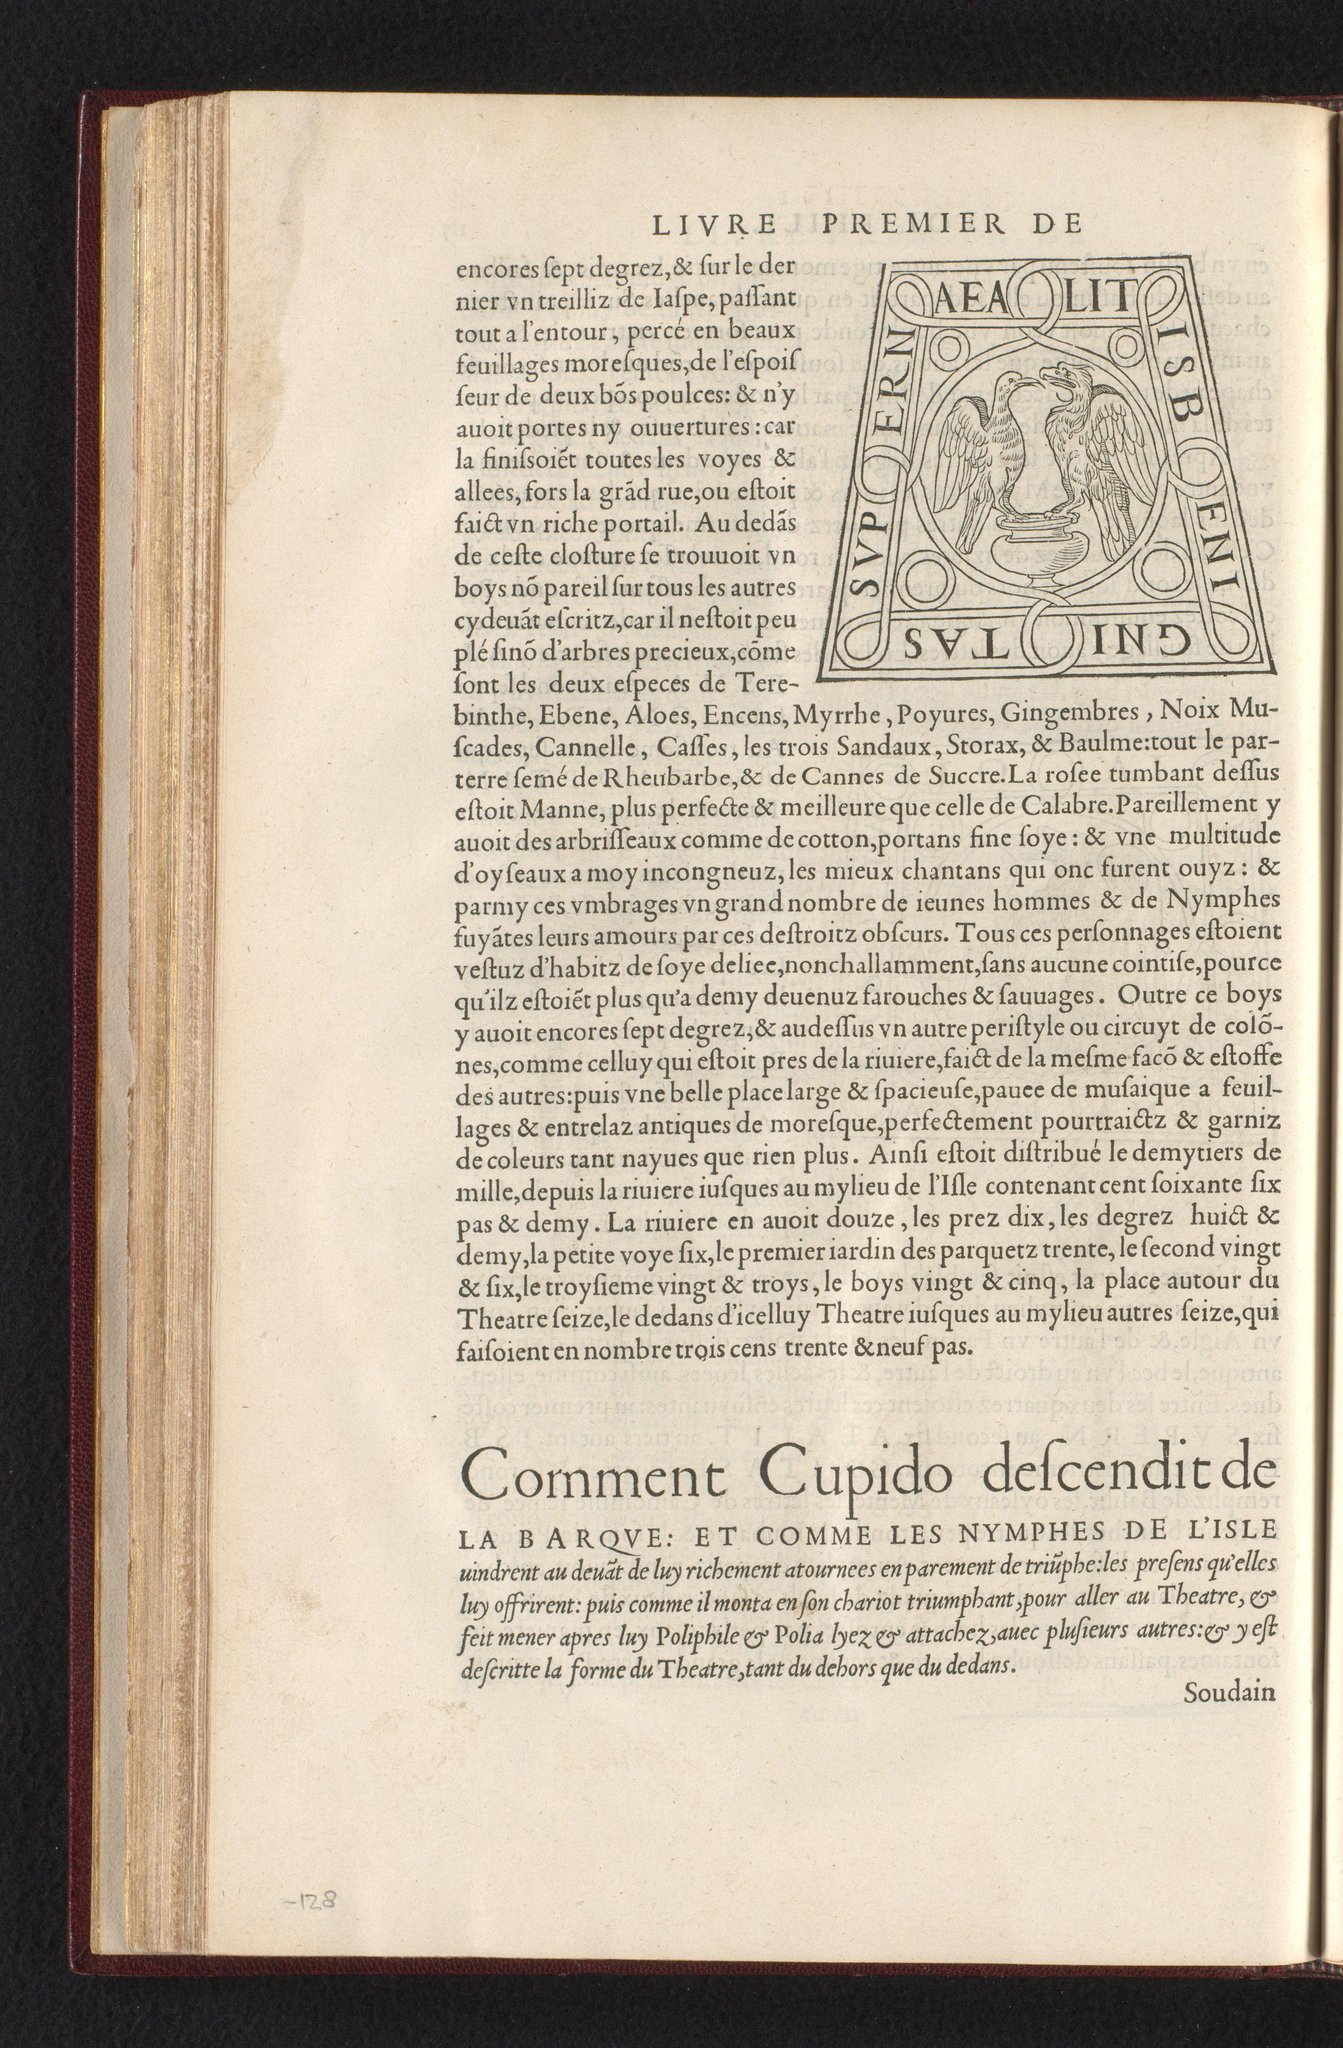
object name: book illustration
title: Ontwerp voor een vloer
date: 1546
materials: paper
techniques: letterpress printing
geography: paris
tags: predatory birds: eagle, (scenes from) specific works of literature: colonna, hypnerotomachia poliphili, pavement, floor ~ architecture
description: Prent uit: Colonna, Francesco. Hypnerotomachie ou discours du songe de Poliphile, deduisant comme amour le combat a l'occasion de Polia. Parijs: Jacques Kerver, 1546, verso fol. 115.